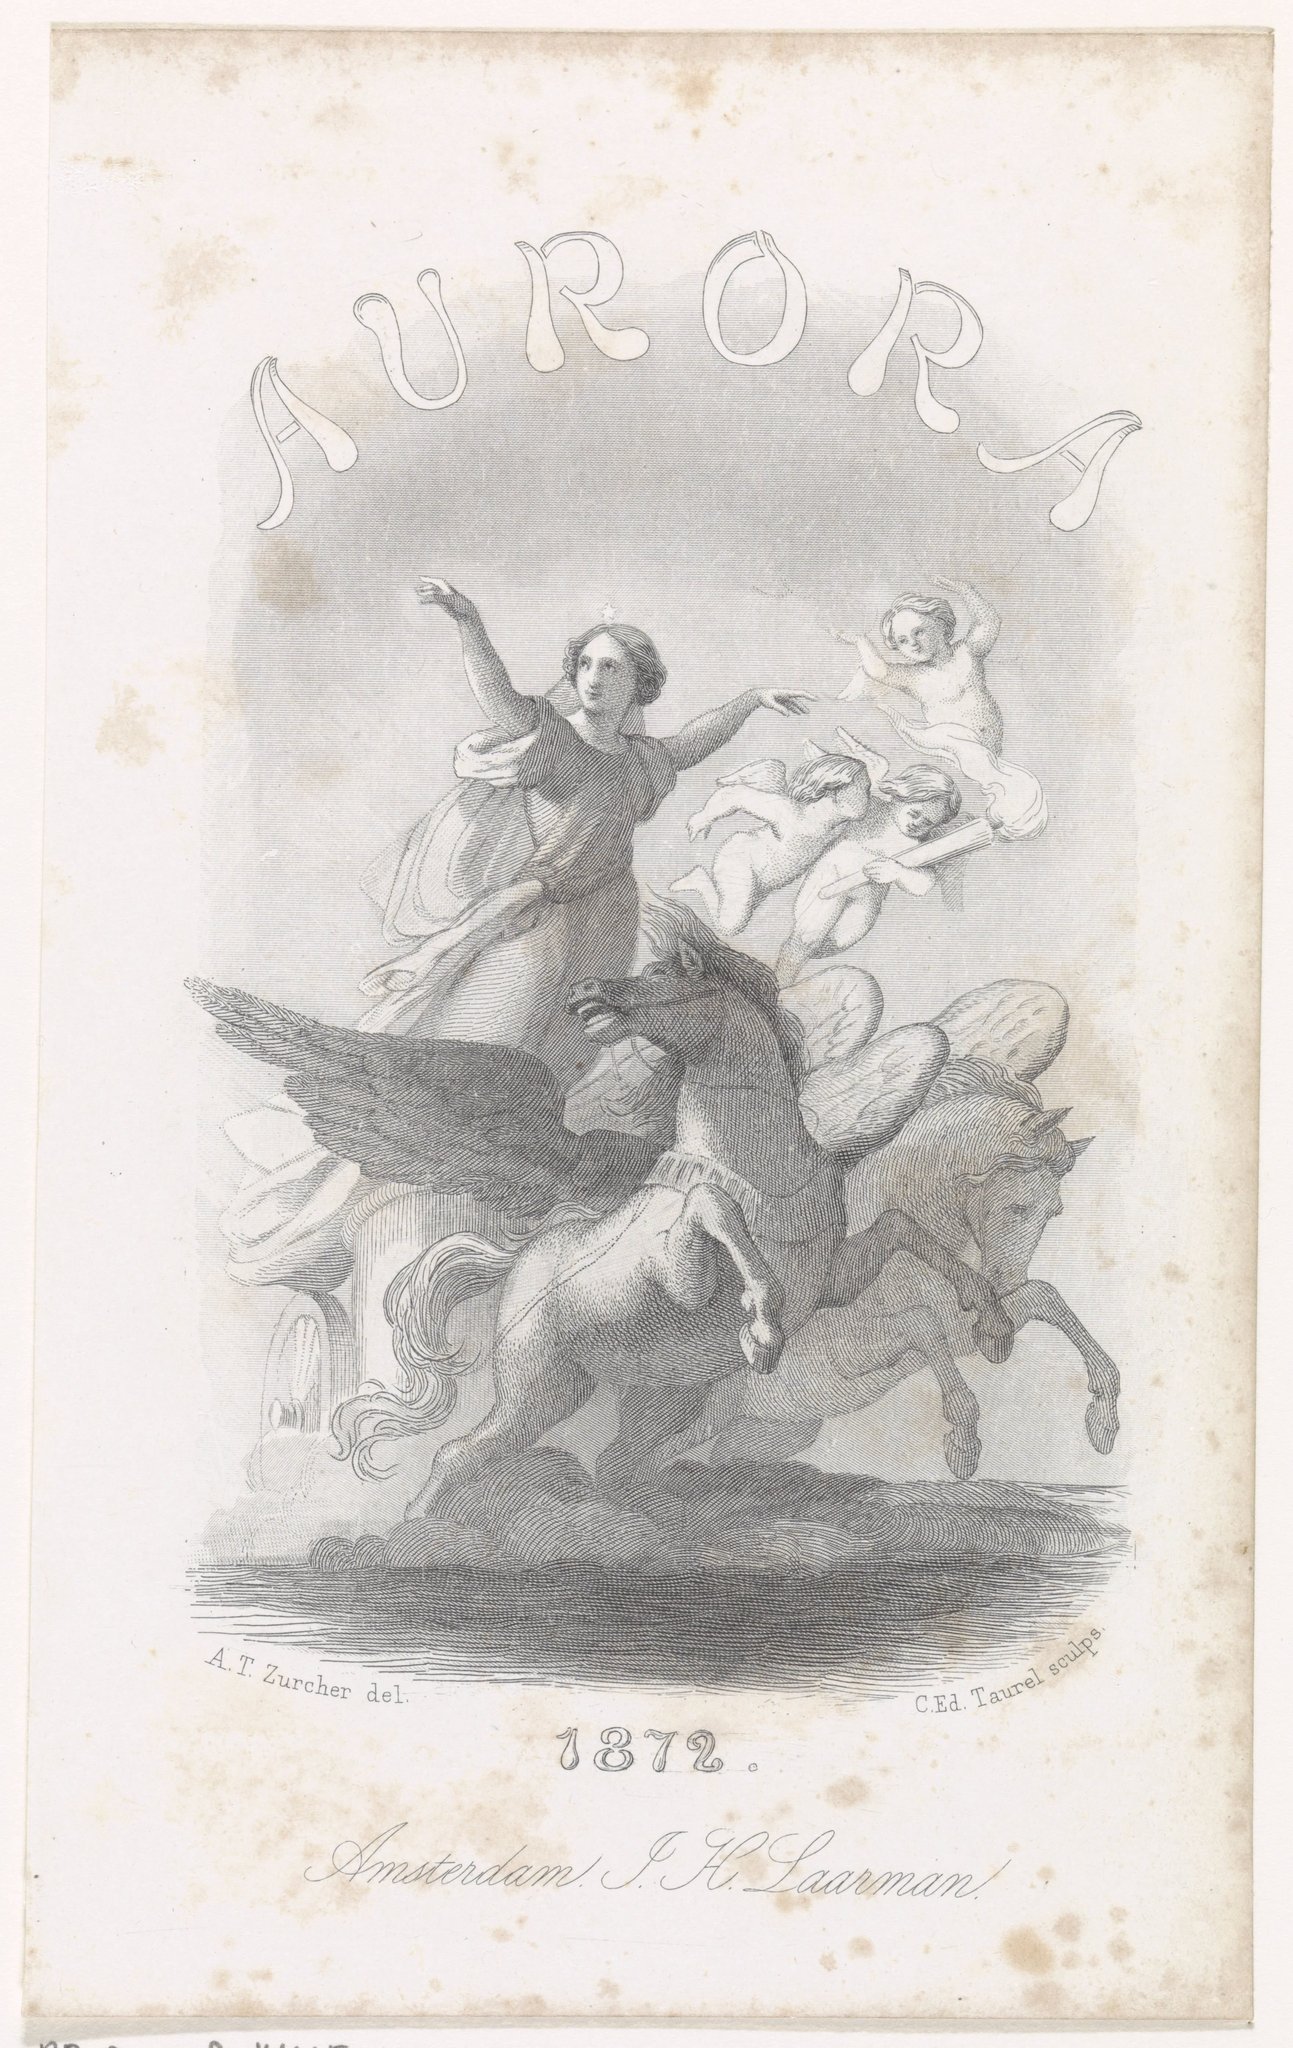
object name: titelblad, titelpagina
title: Aurora op een door twee gevleugelde paarden getrokken wagen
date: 1872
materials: paper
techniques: engraving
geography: amsterdam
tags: personification of the morning, 'aurora'; 'aurora' (ripa), (story of) aurora (eos); 'aurora' (ripa)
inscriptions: collector's mark: Lugt 2228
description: De godin van het ochtendgloren, Aurora, staand op een door twee gevleugelde paarden getrokken wagen. In de lucht drie putti waarvan één een brandende fakkel vasthoudt.